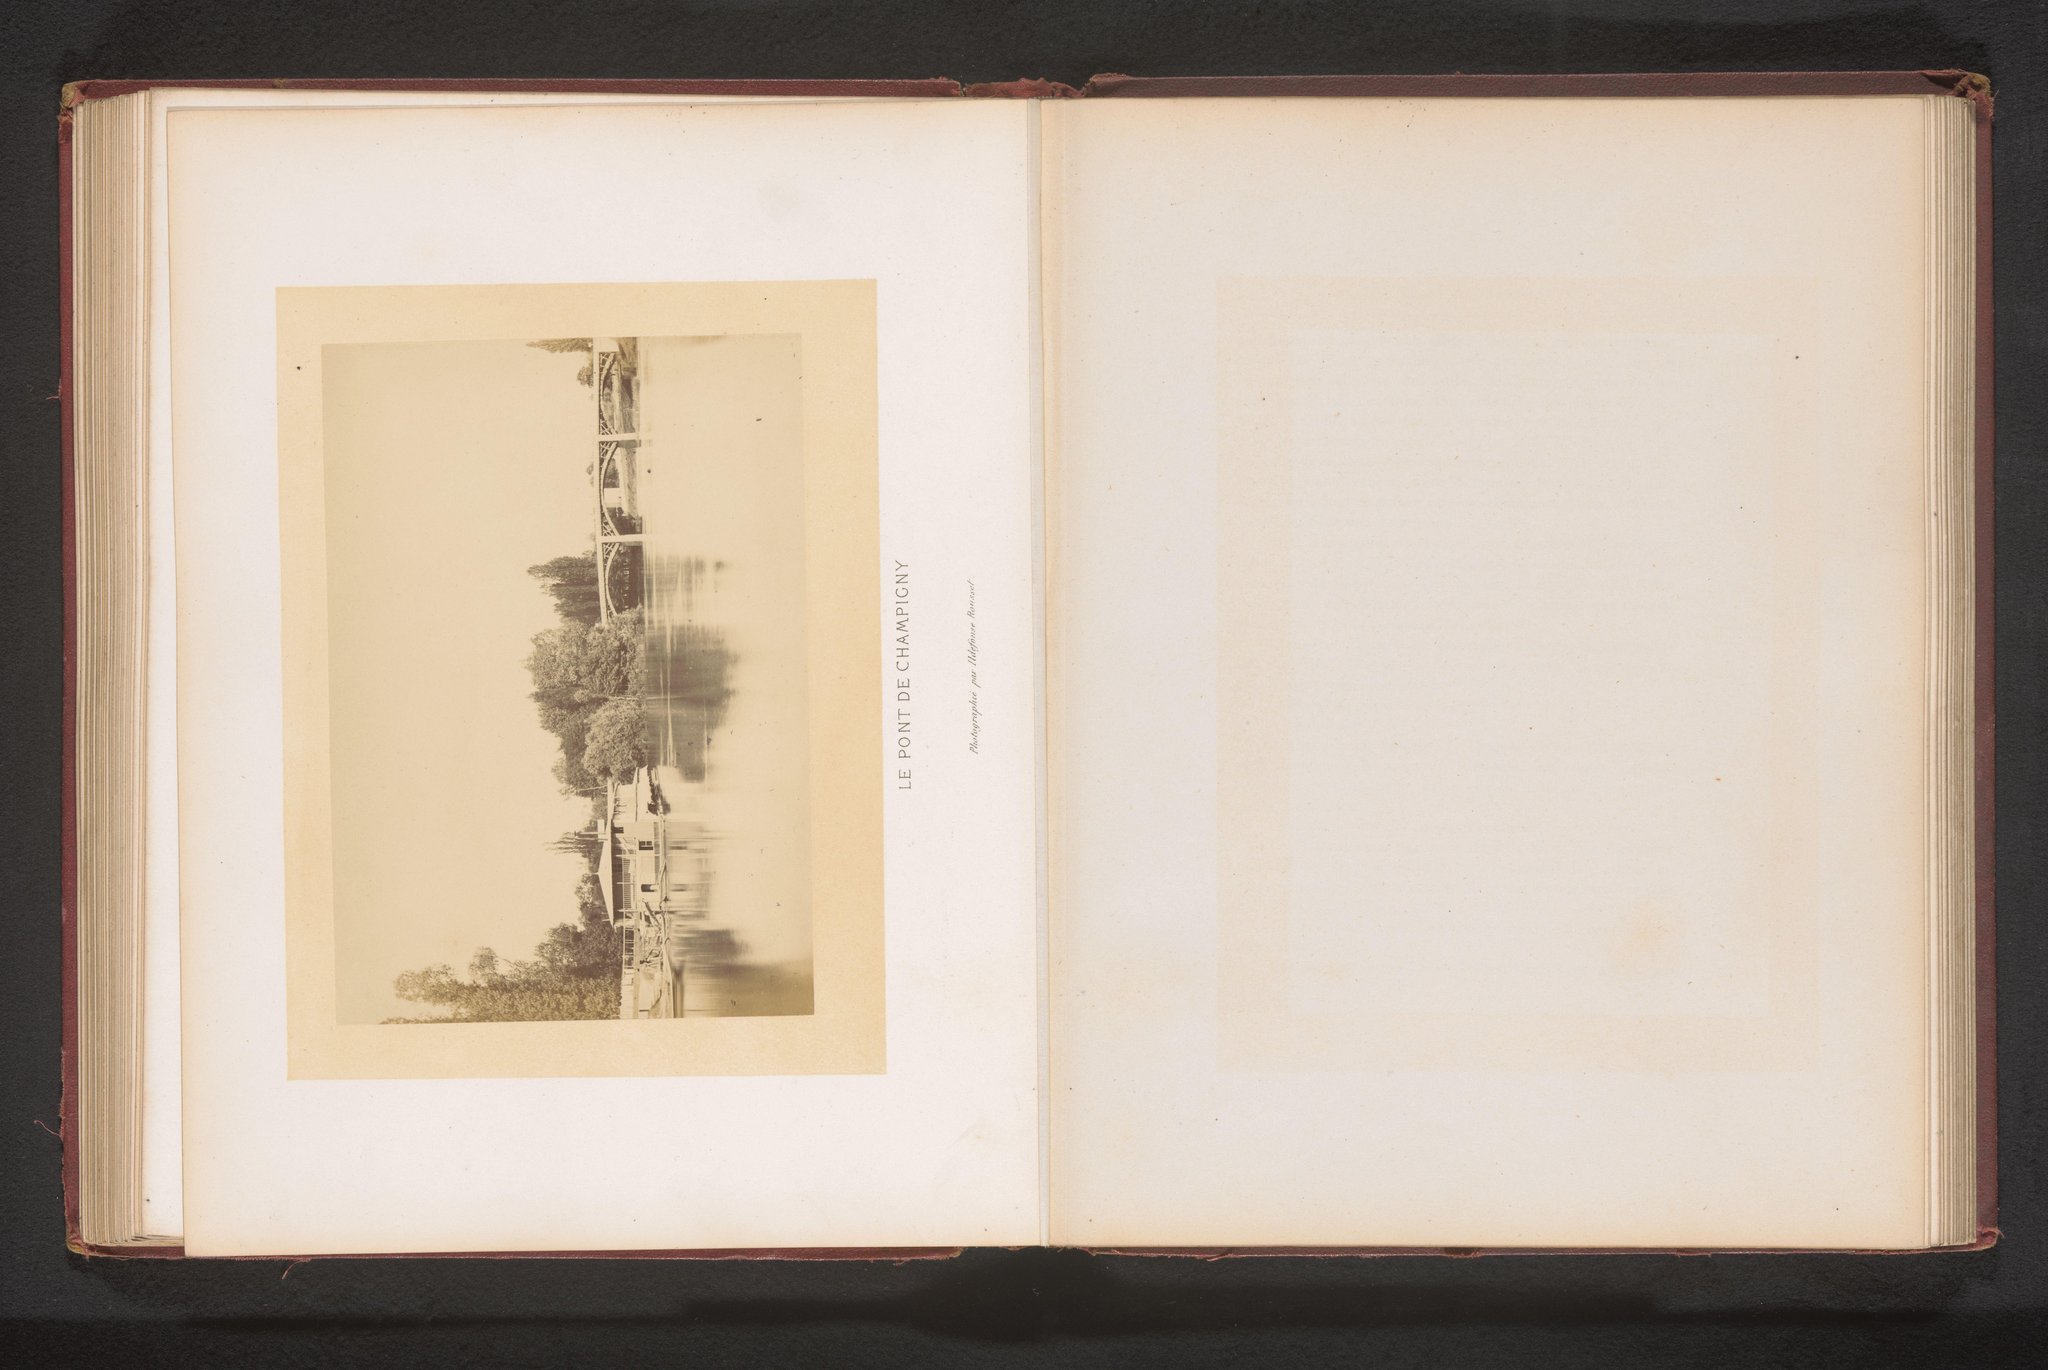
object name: photograph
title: Gezicht op de Pont de Champigny te Champigny-sur-Marne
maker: ildefonse rousset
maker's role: fotograaf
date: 1860-1865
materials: photographic support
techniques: albumen print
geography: ile-de-france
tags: river, bridge